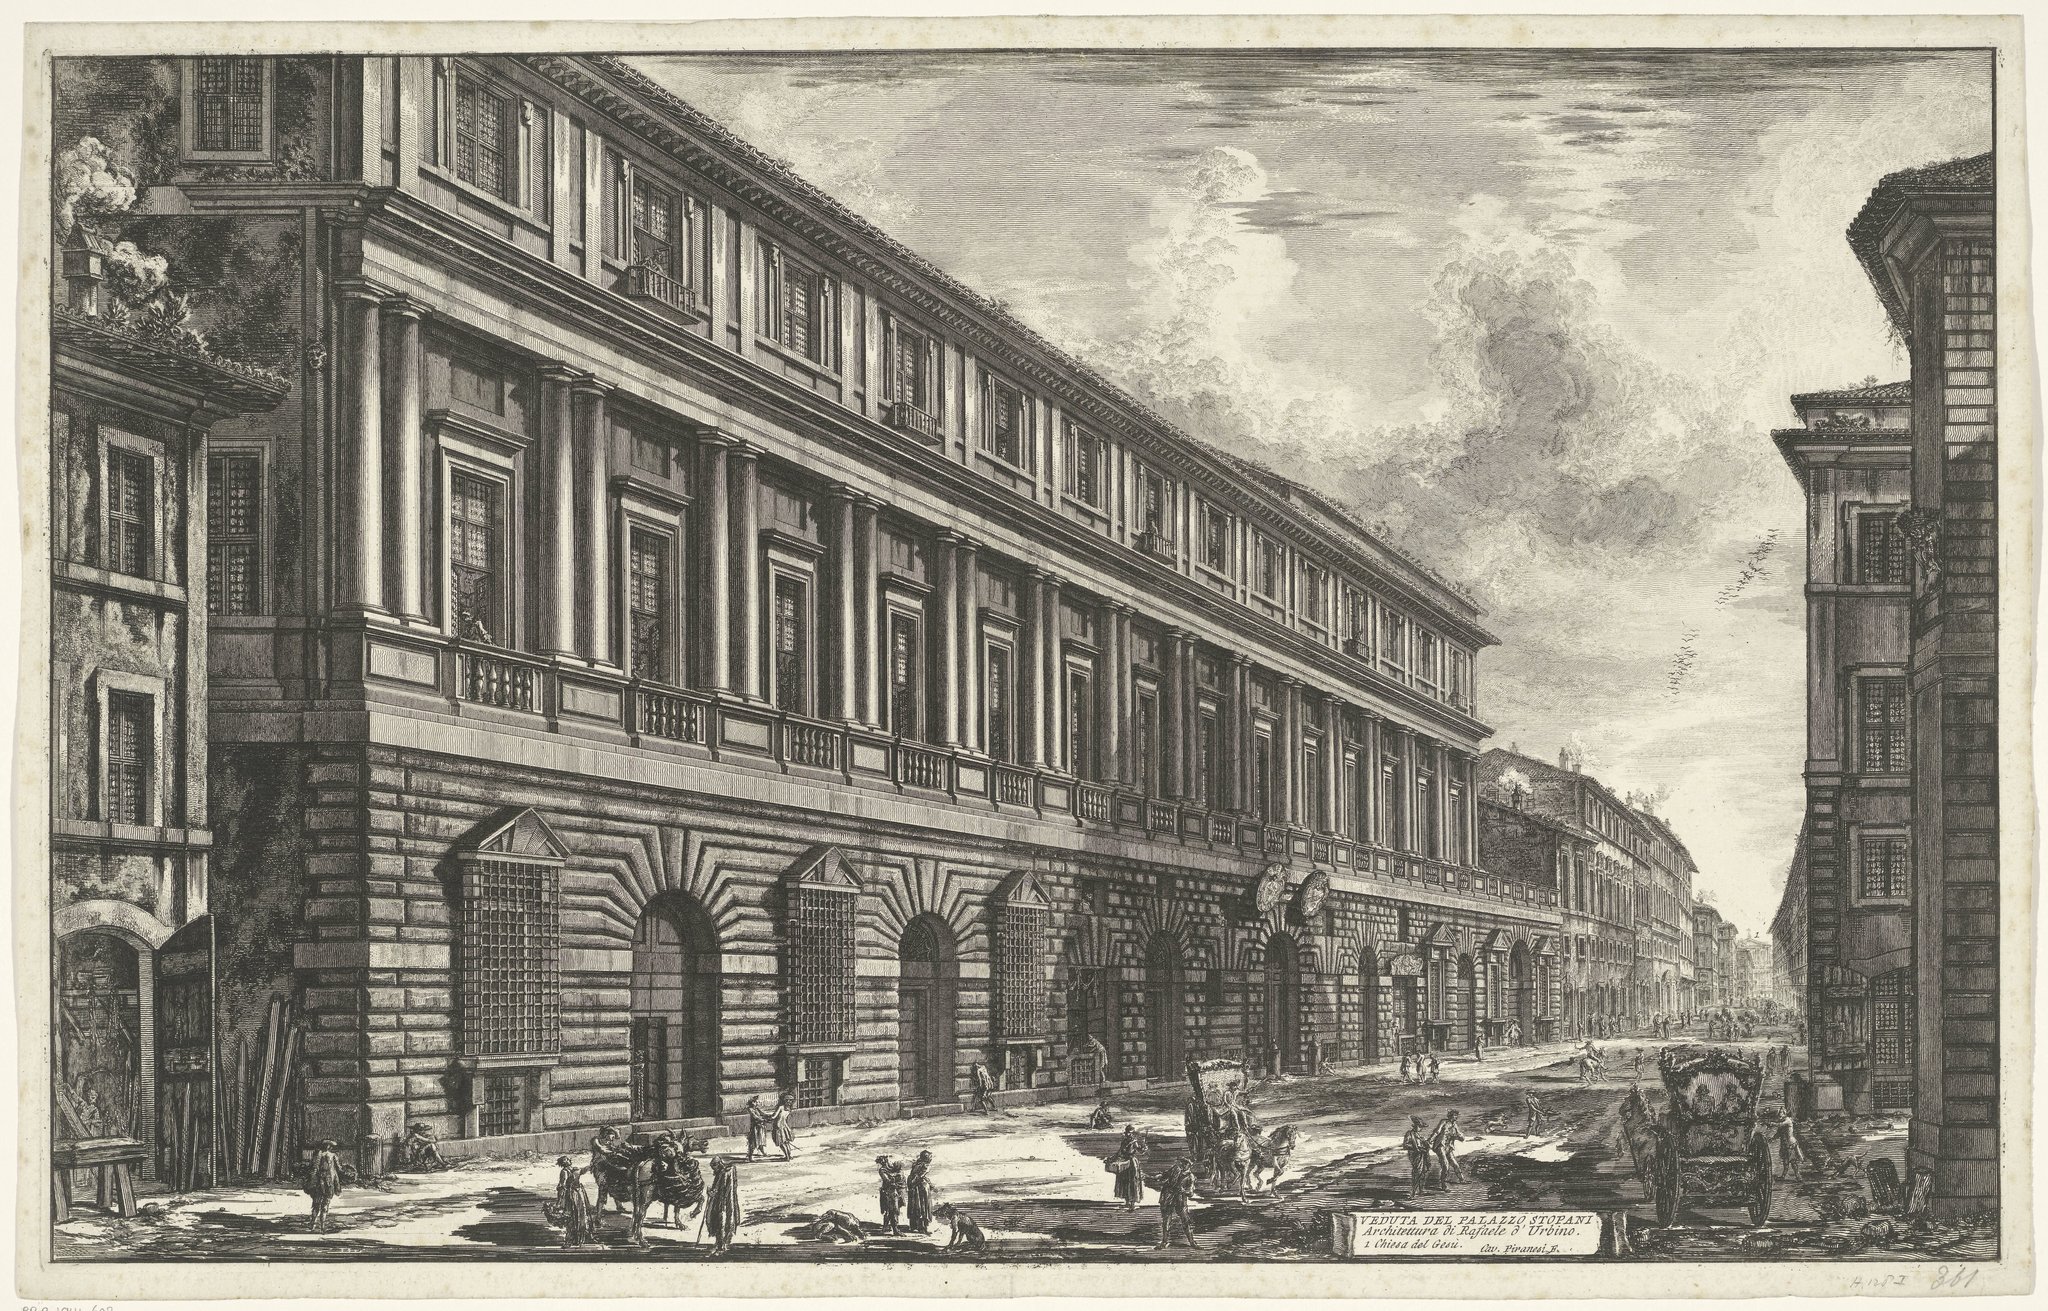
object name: print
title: Palazzo Vidoni Caffarelli te Rome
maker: giovanni battista piranesi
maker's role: designer, draughtsman, print maker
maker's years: 1720-1778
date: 1748-1778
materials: paper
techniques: etching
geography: rome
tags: hôtel, i.e. small palace in city, rome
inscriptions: collector's mark: Lugt 2228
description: Deze prent maakt deel uit van de serie 'Vedute di Roma'. Piranesi werkte aan deze 135 platen tellende serie tussen 1748 en zijn dood in 1778. Francesco Piranesi voegde later nog twee prenten toe aan de reeks van zijn vader.